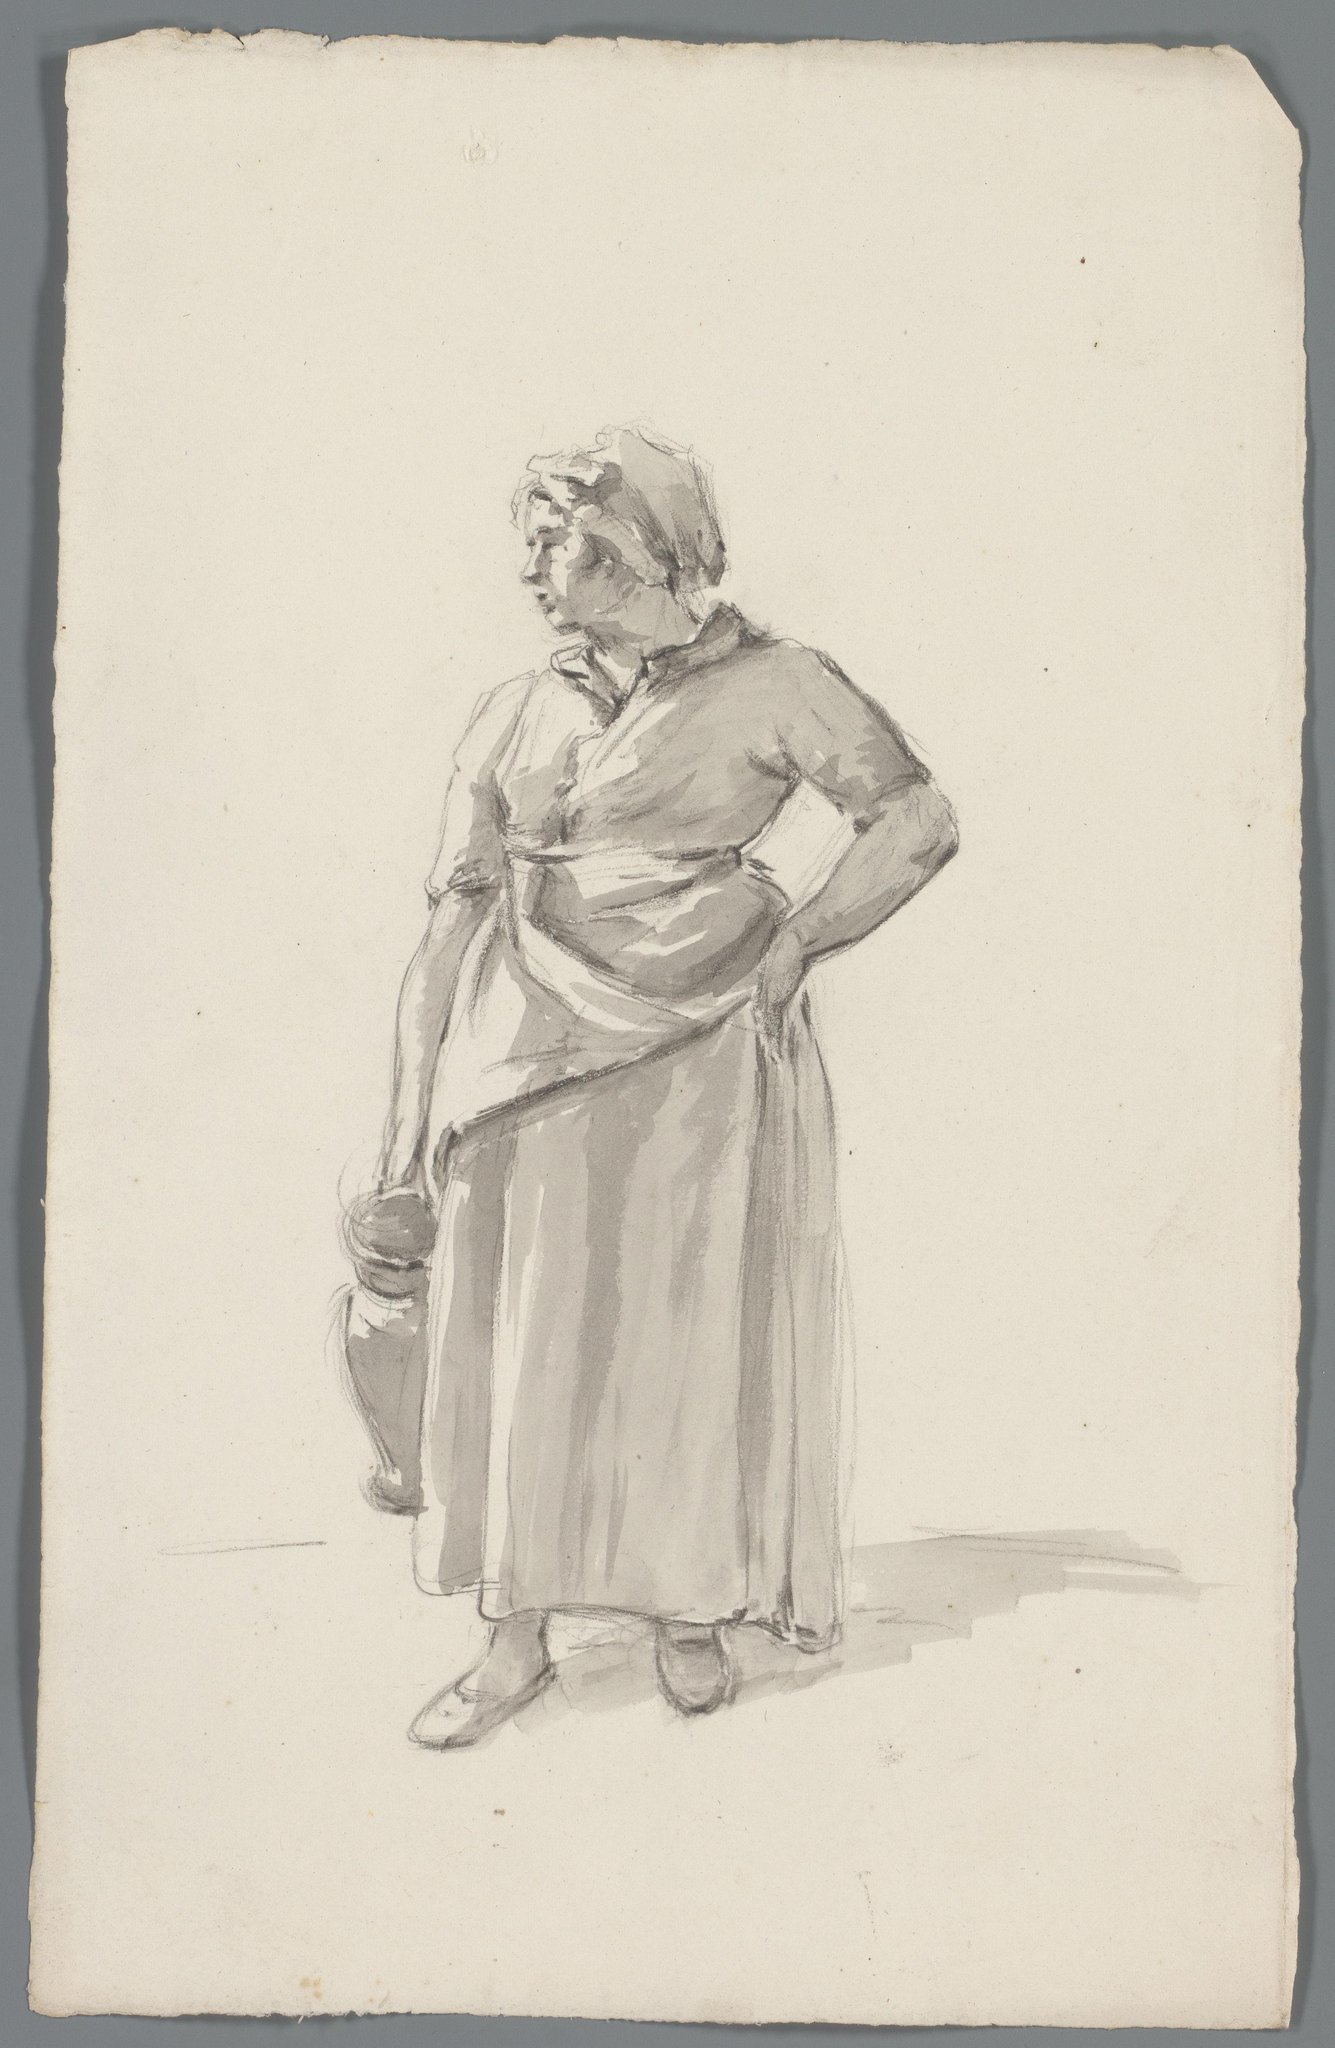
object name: drawing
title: Vrouw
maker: Anonymous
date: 1820-1830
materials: chalk, paper, watercolor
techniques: brush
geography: the hague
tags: adult woman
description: Tekeningen waarschijnlijk ontstaan bij het Haagse kunstgenootschap ‘Tot Nut der Tekenkunst’, waar twee keer per week tekenavonden werden georganiseerd met geklede modellen.